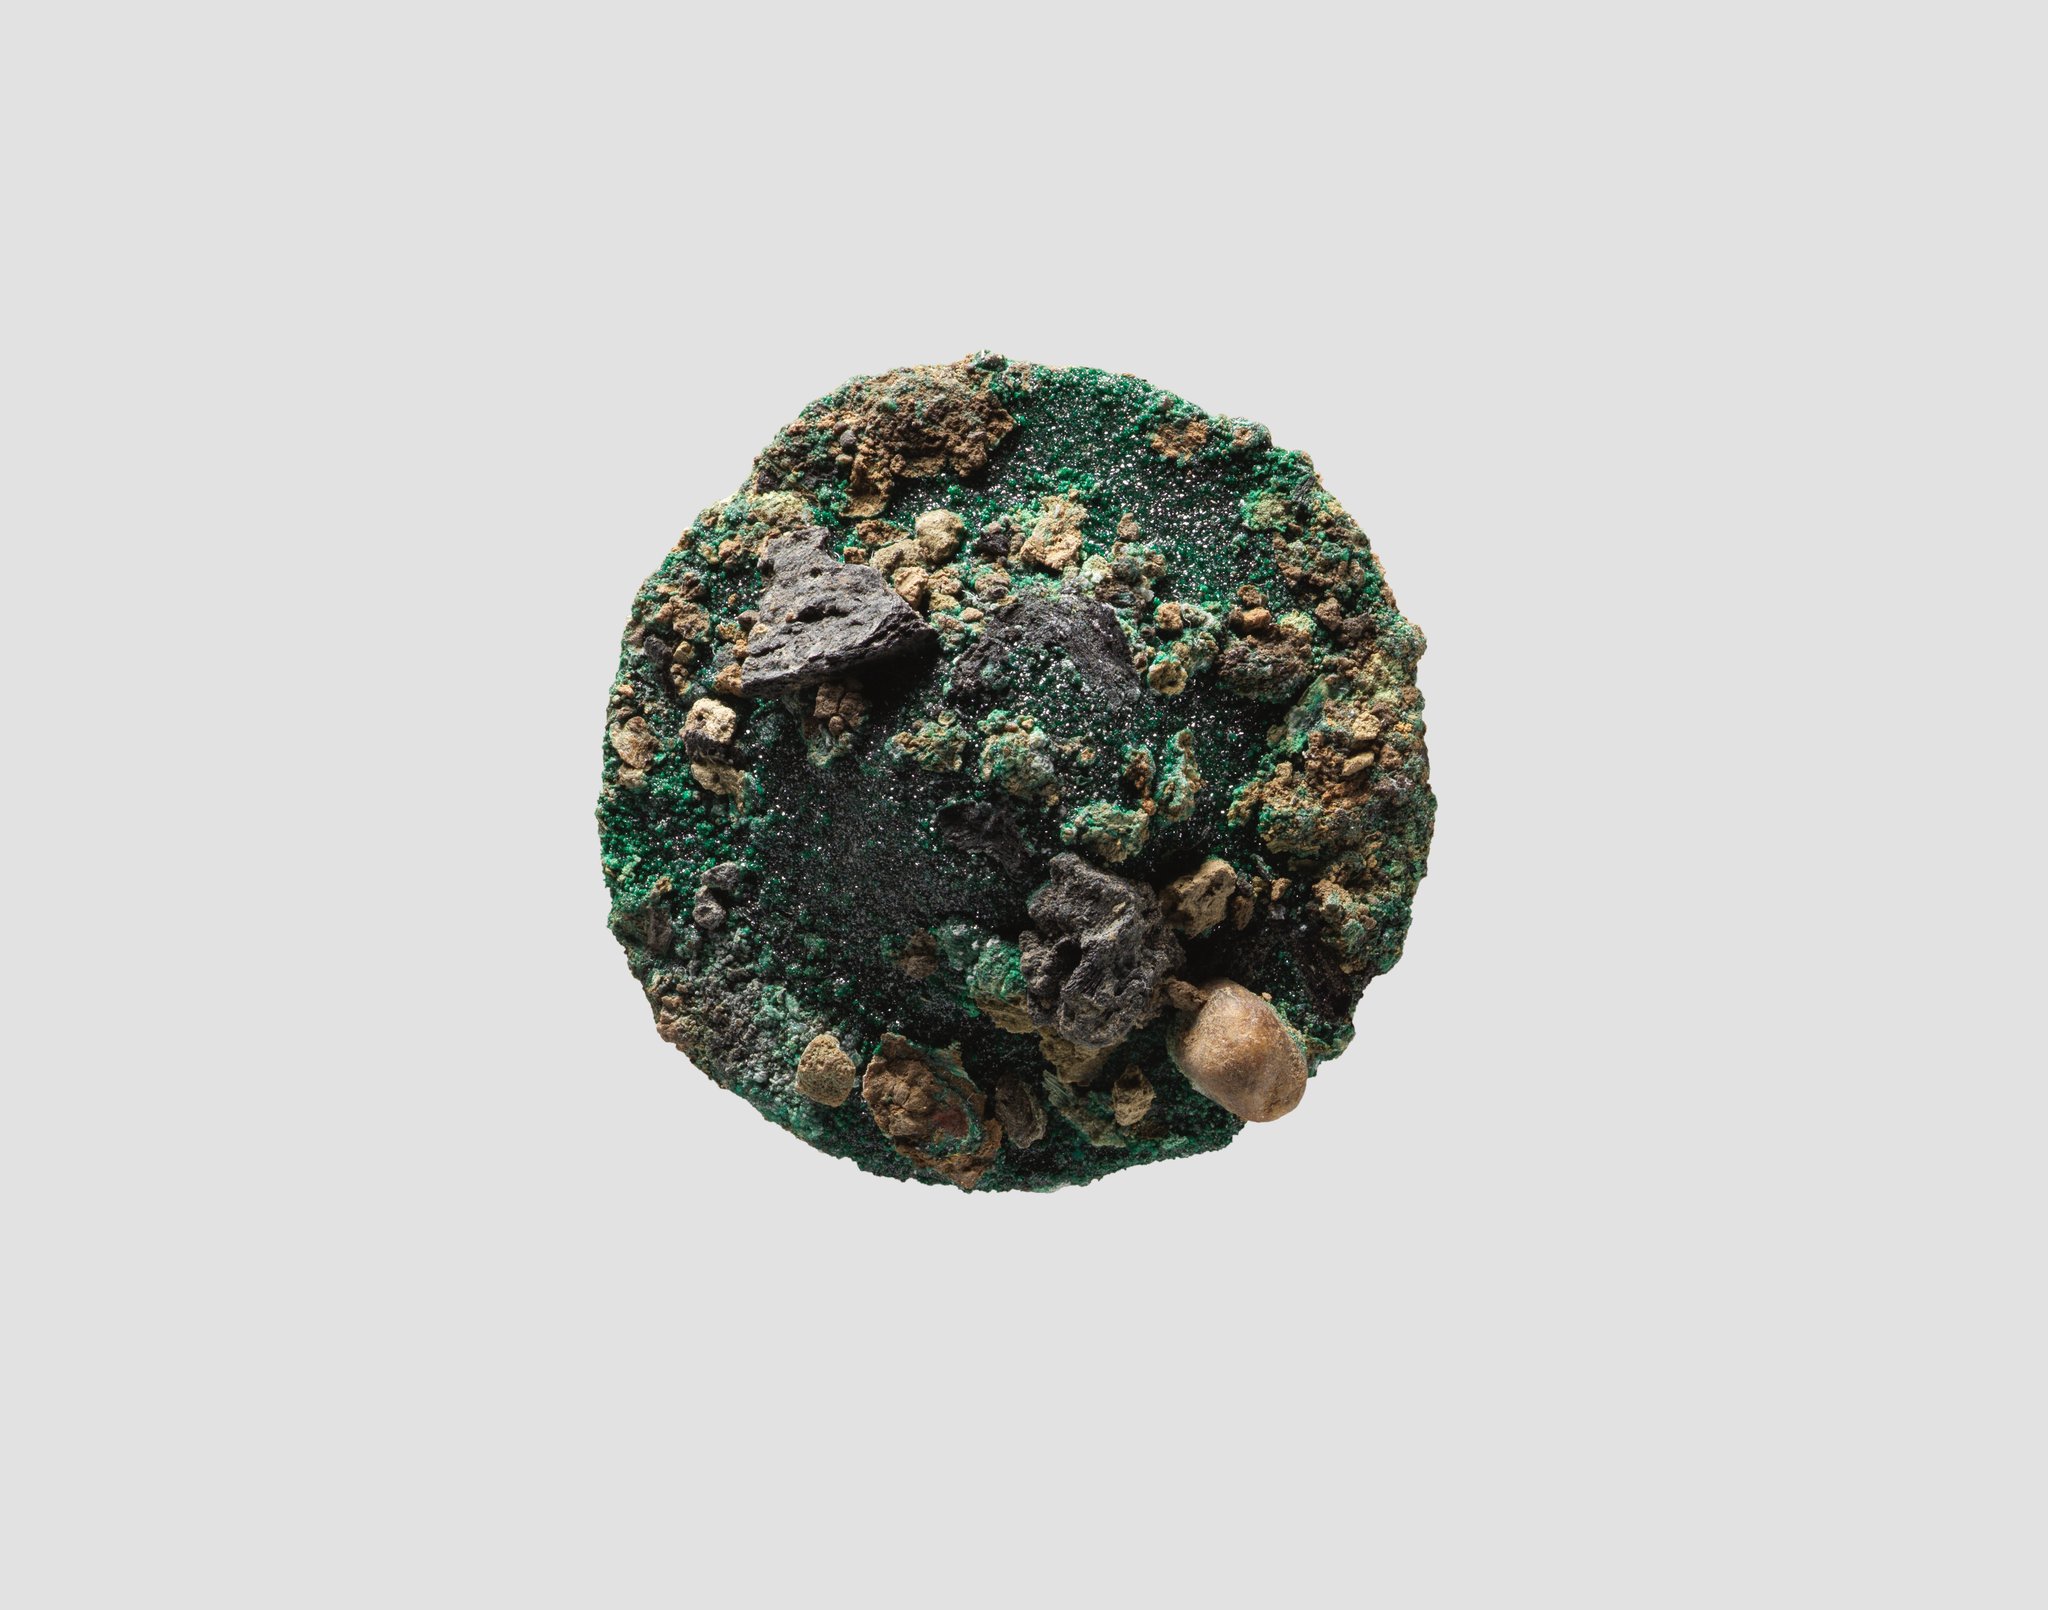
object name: stud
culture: iranian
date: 900-801 BCE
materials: bronze, copper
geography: iran